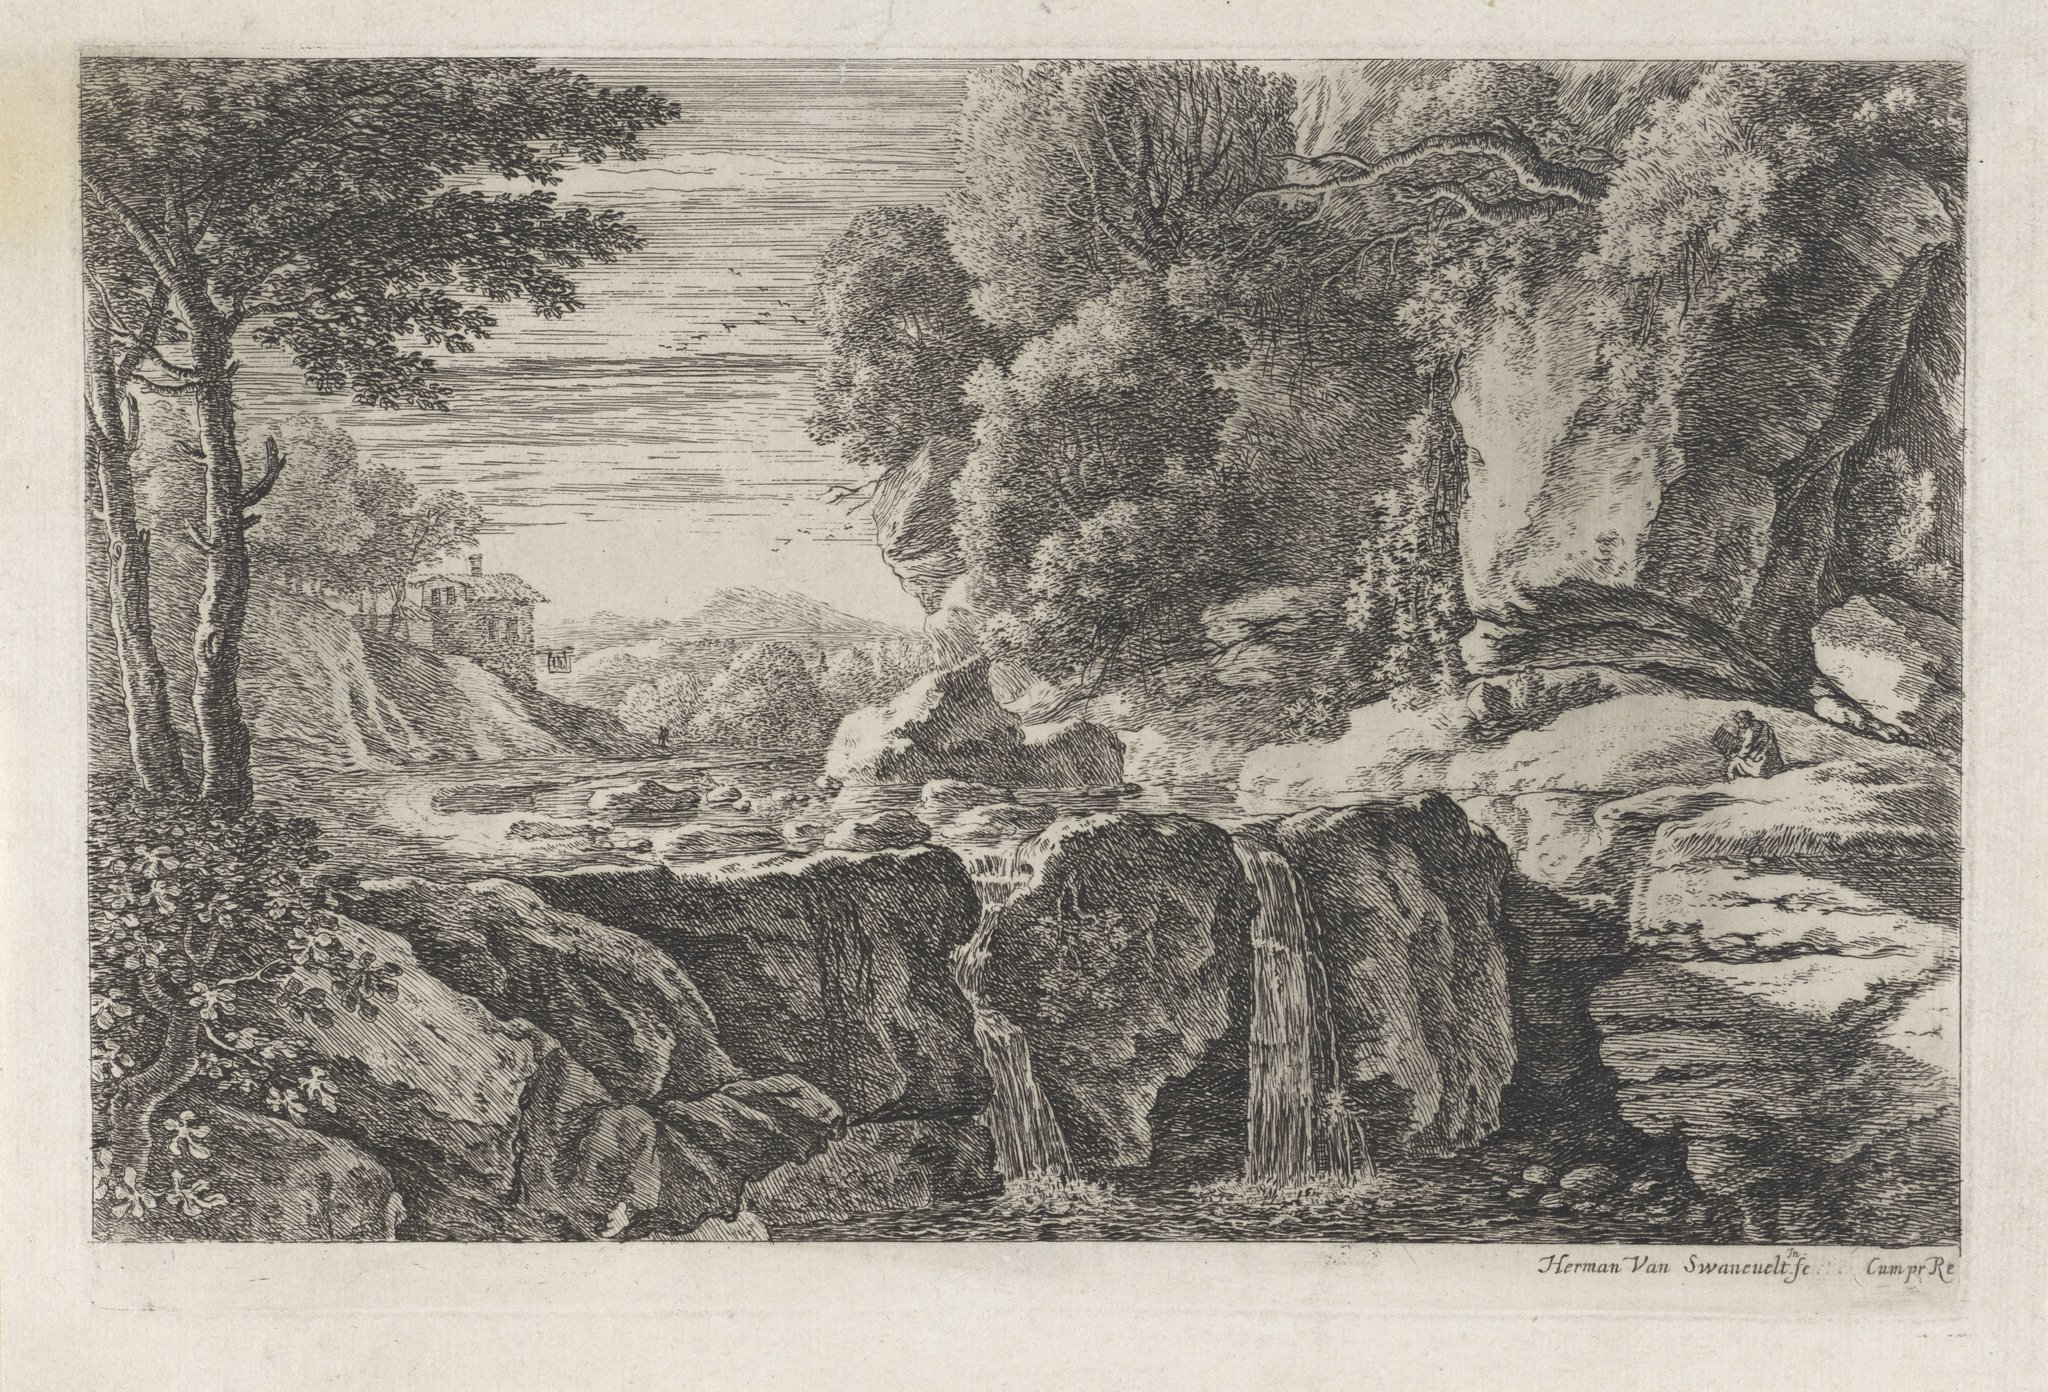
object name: print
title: Landschap met kleine waterval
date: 1643-1655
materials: paper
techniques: etching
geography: paris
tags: river, waterfall, rural housing, e.g. country-house, villa, cottage, (high) hill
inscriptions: collector's mark: Lugt 2228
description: Een lezende of schrijvende figuur zit bij een kleine waterval. In de verte staat een gebouw aan de voet van een heuvel.